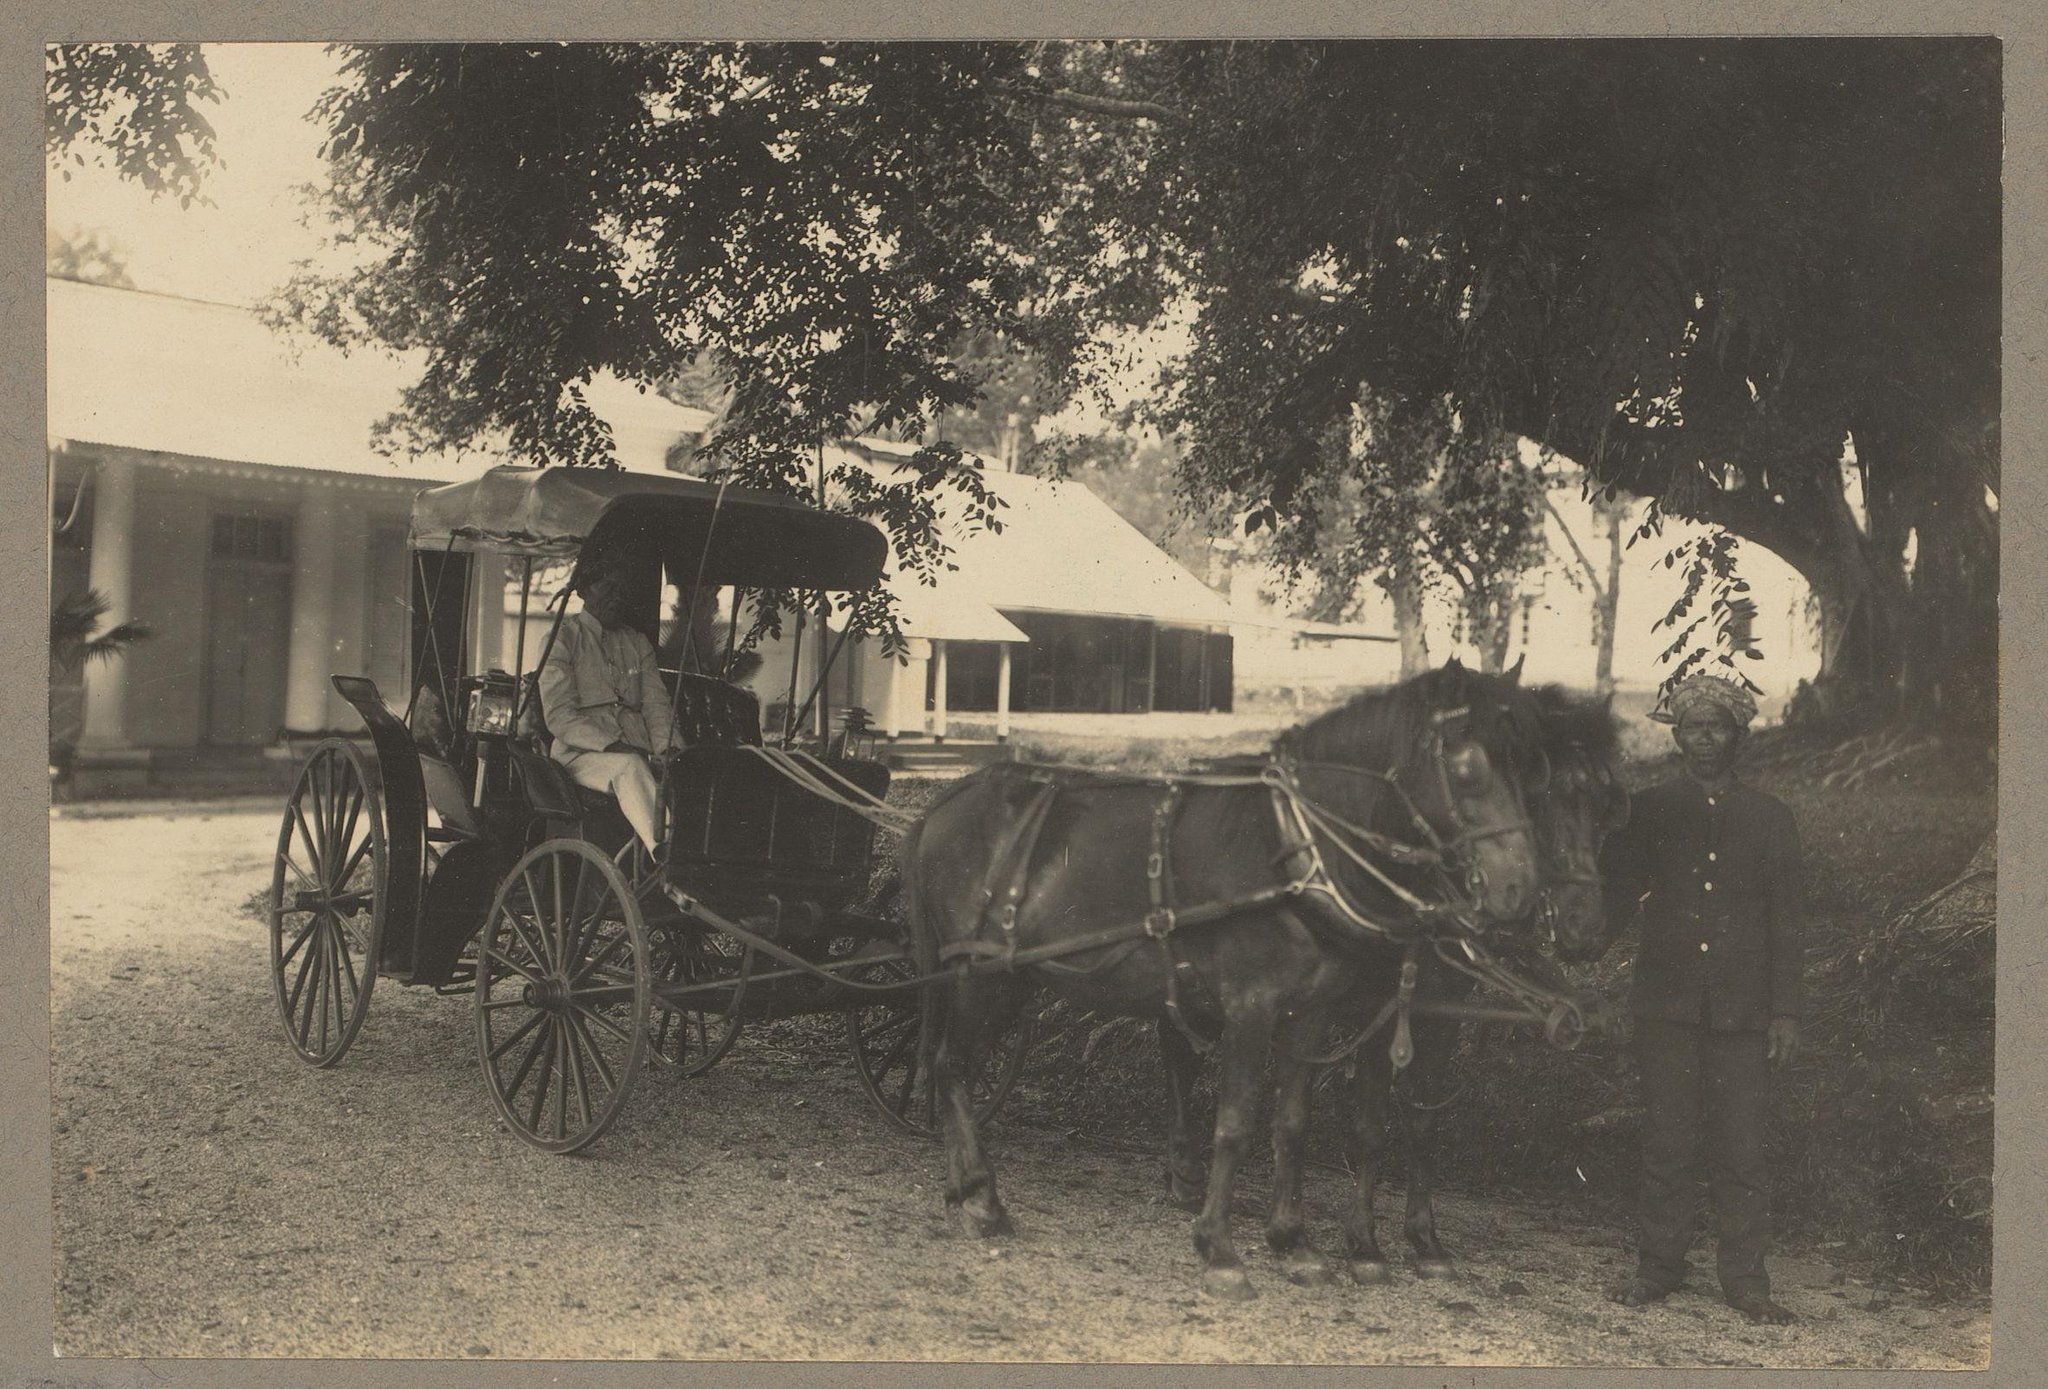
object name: photograph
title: Rijtuig en paarden Chef Banka-tinwinning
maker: Anonymous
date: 1914-1919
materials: photographic support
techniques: gelatin silver print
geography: bangka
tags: robert julius boers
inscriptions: inscription: ‘Rijtuig en paarden Chef Banka-tinwinning’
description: Het rijtuig met paarden ter beschikking staande van de chef van het hoofdbureau van de Banka-tinwinning te Muntok. Met Indische koetsenier en paardenknecht. Onderdeel van het fotoalbum aangeboden aan Robert Julius Boers bij zijn vertrek naar Nederland in 1919 door het personeel van de Banka-tinwinning.